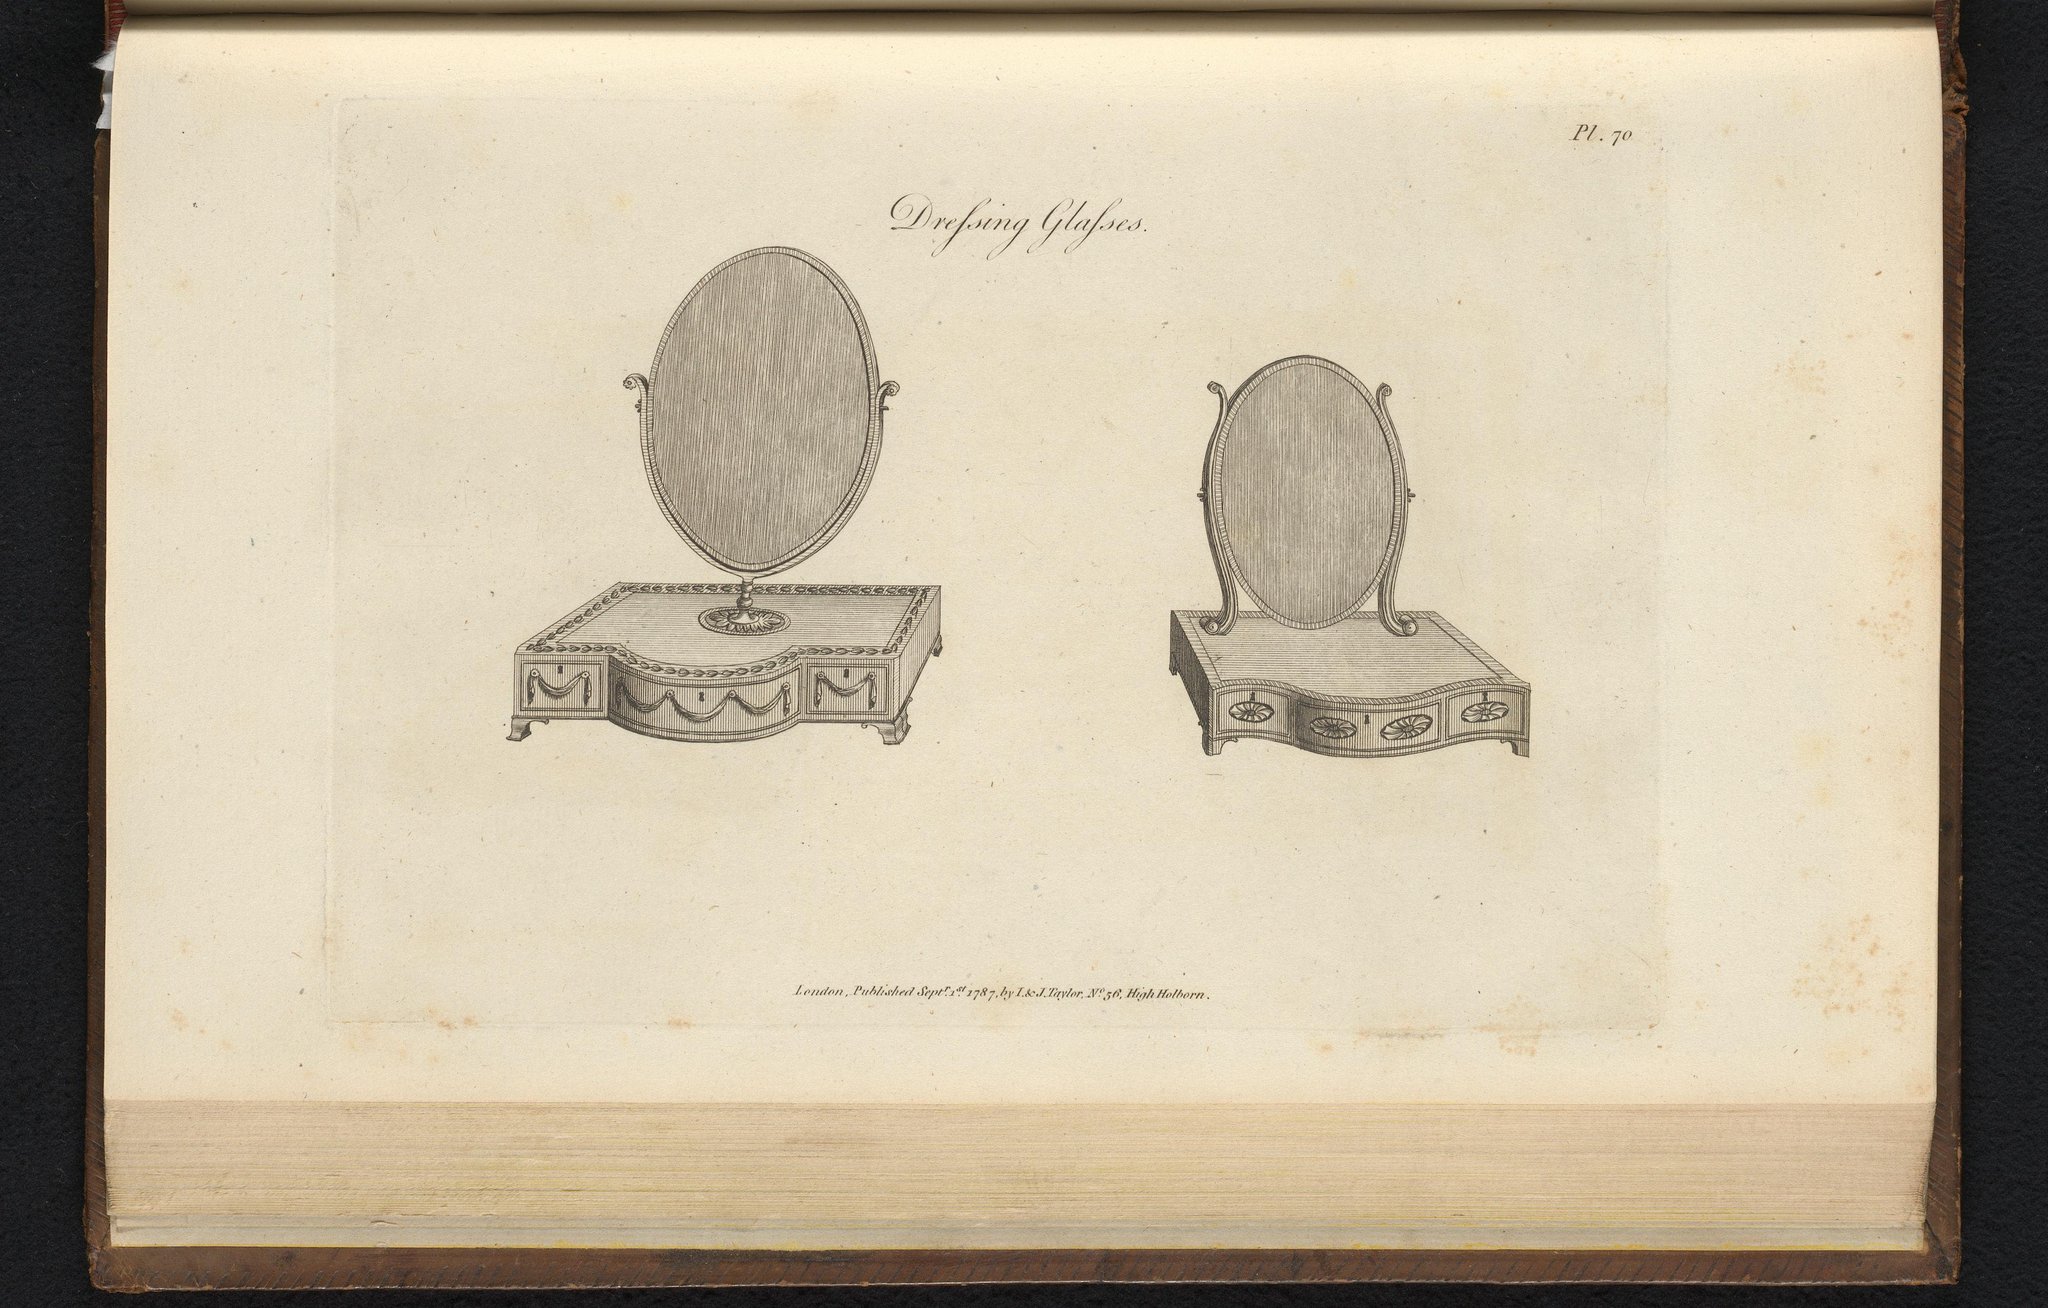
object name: print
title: Twee spiegels voor op dressoirs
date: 1787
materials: paper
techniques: engraving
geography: holborn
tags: mirror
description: Genummerd: Pl. 70. Prent maakt deel uit van een boek.